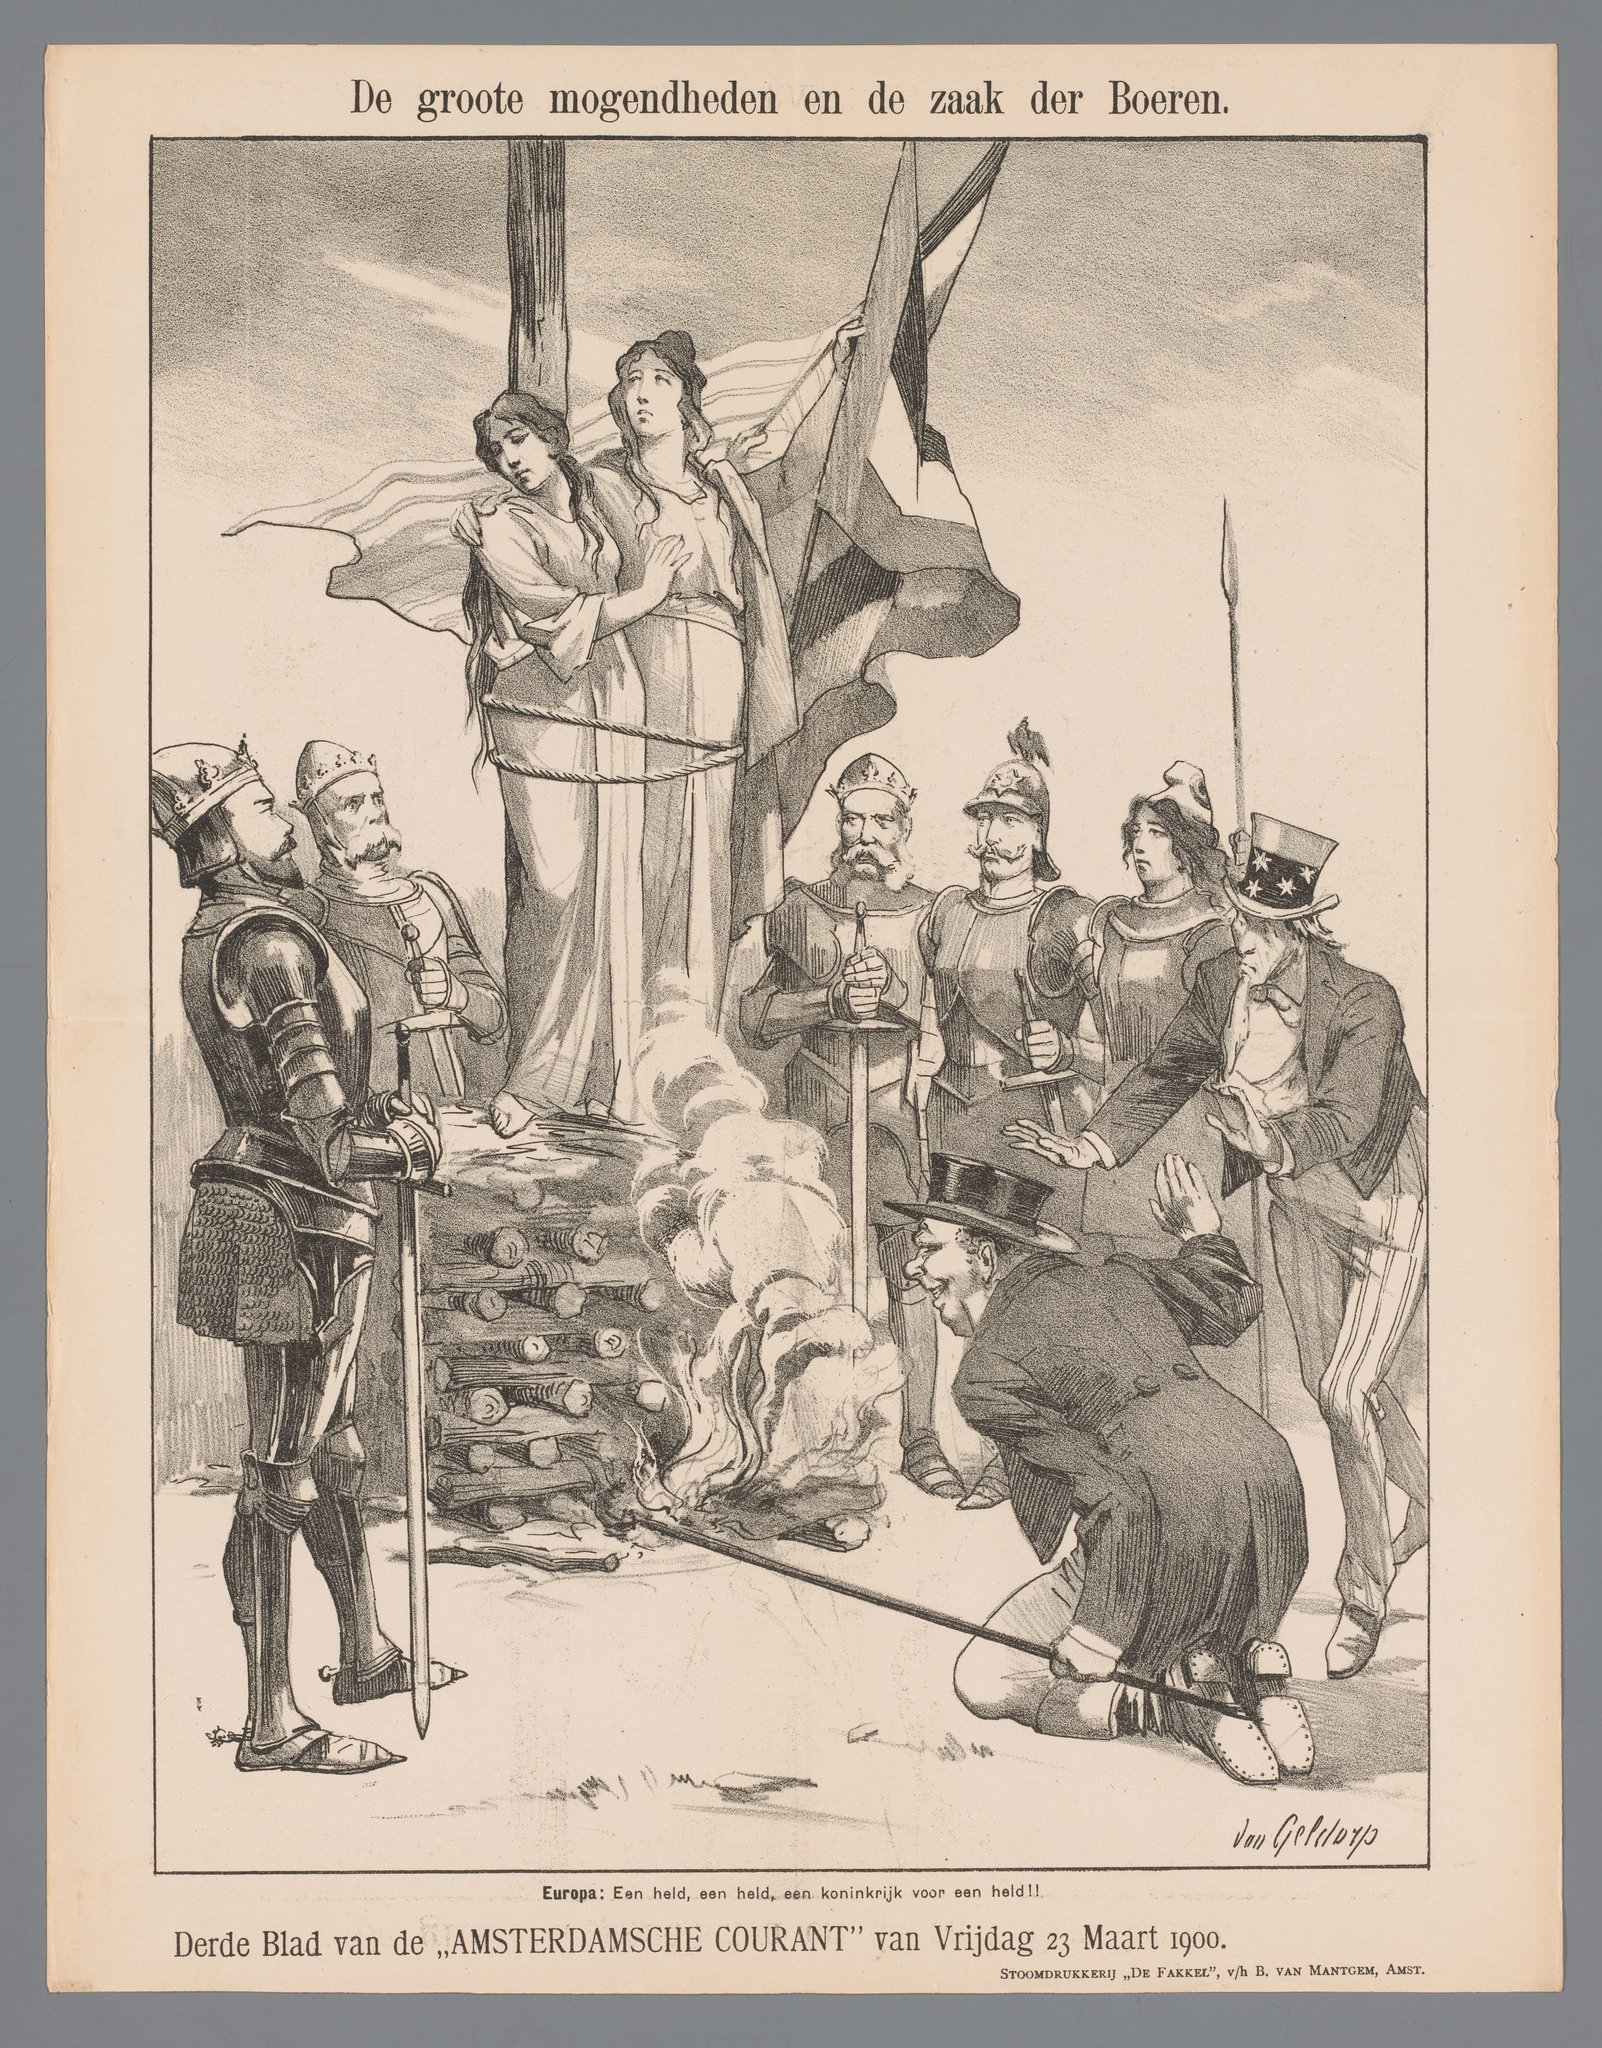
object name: cartoon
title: De groote mogendheden en de zaak der Boeren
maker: petrus van geldorp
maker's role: draughtsman, print maker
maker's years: 1872-1939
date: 1900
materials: paper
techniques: lithograph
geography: amsterdam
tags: personifications of countries, nations, states, districts, etc., violent death by burning at the stake; pyre, ruler, sovereign, political caricatures and satires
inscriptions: date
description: Prent uit het bijvoegsel van: De Amsterdamsche Courant, 23 maart 1900.